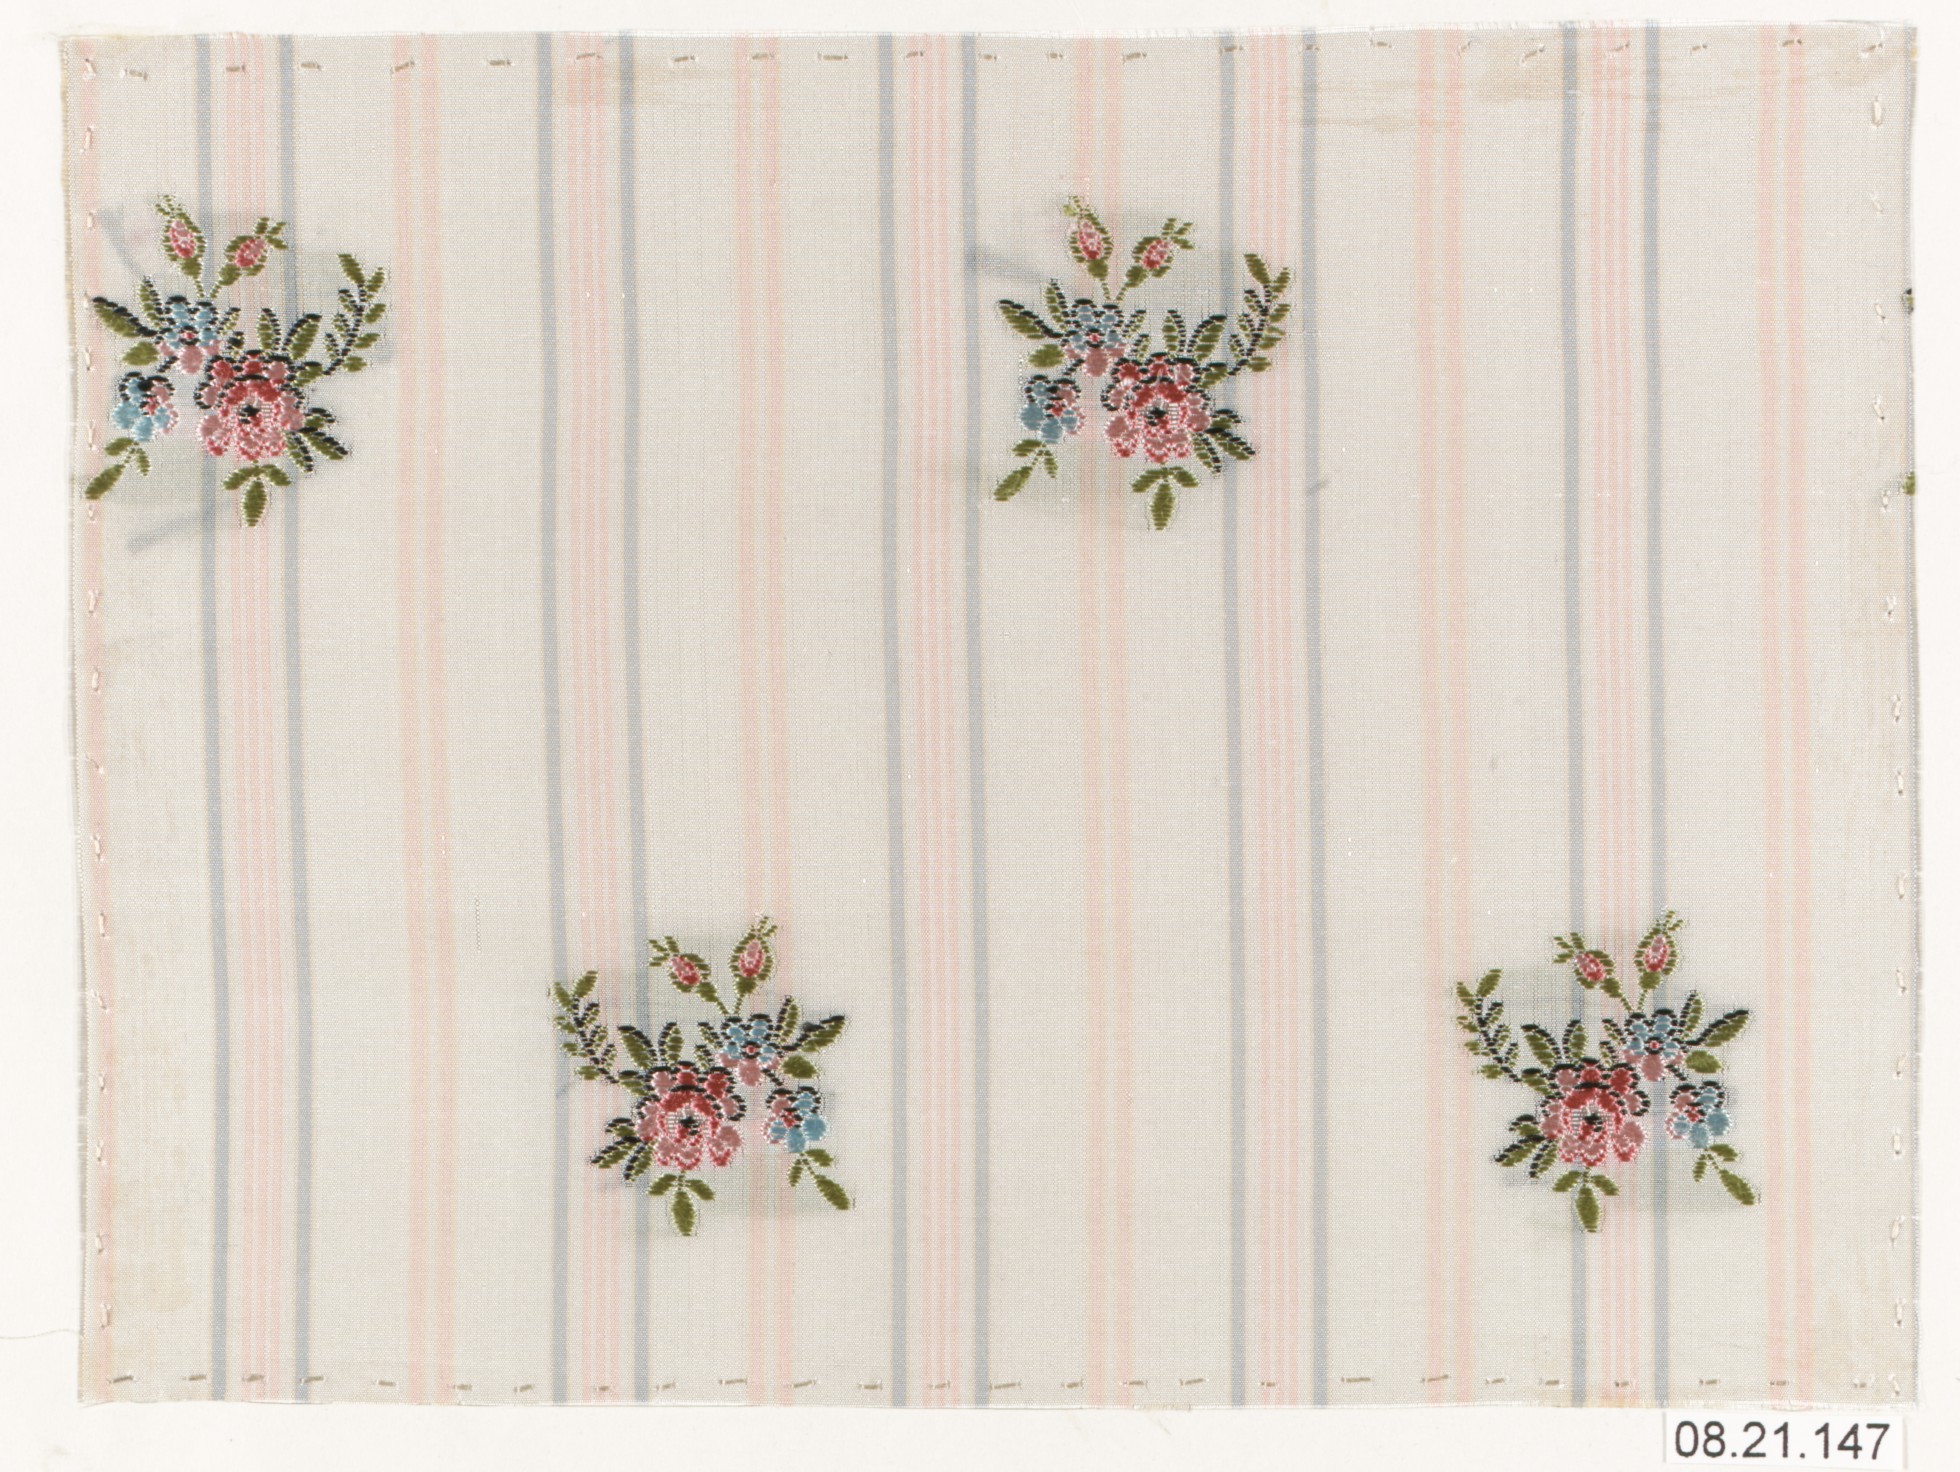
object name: textile sample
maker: Anonymous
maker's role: designer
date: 1900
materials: silk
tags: flowers